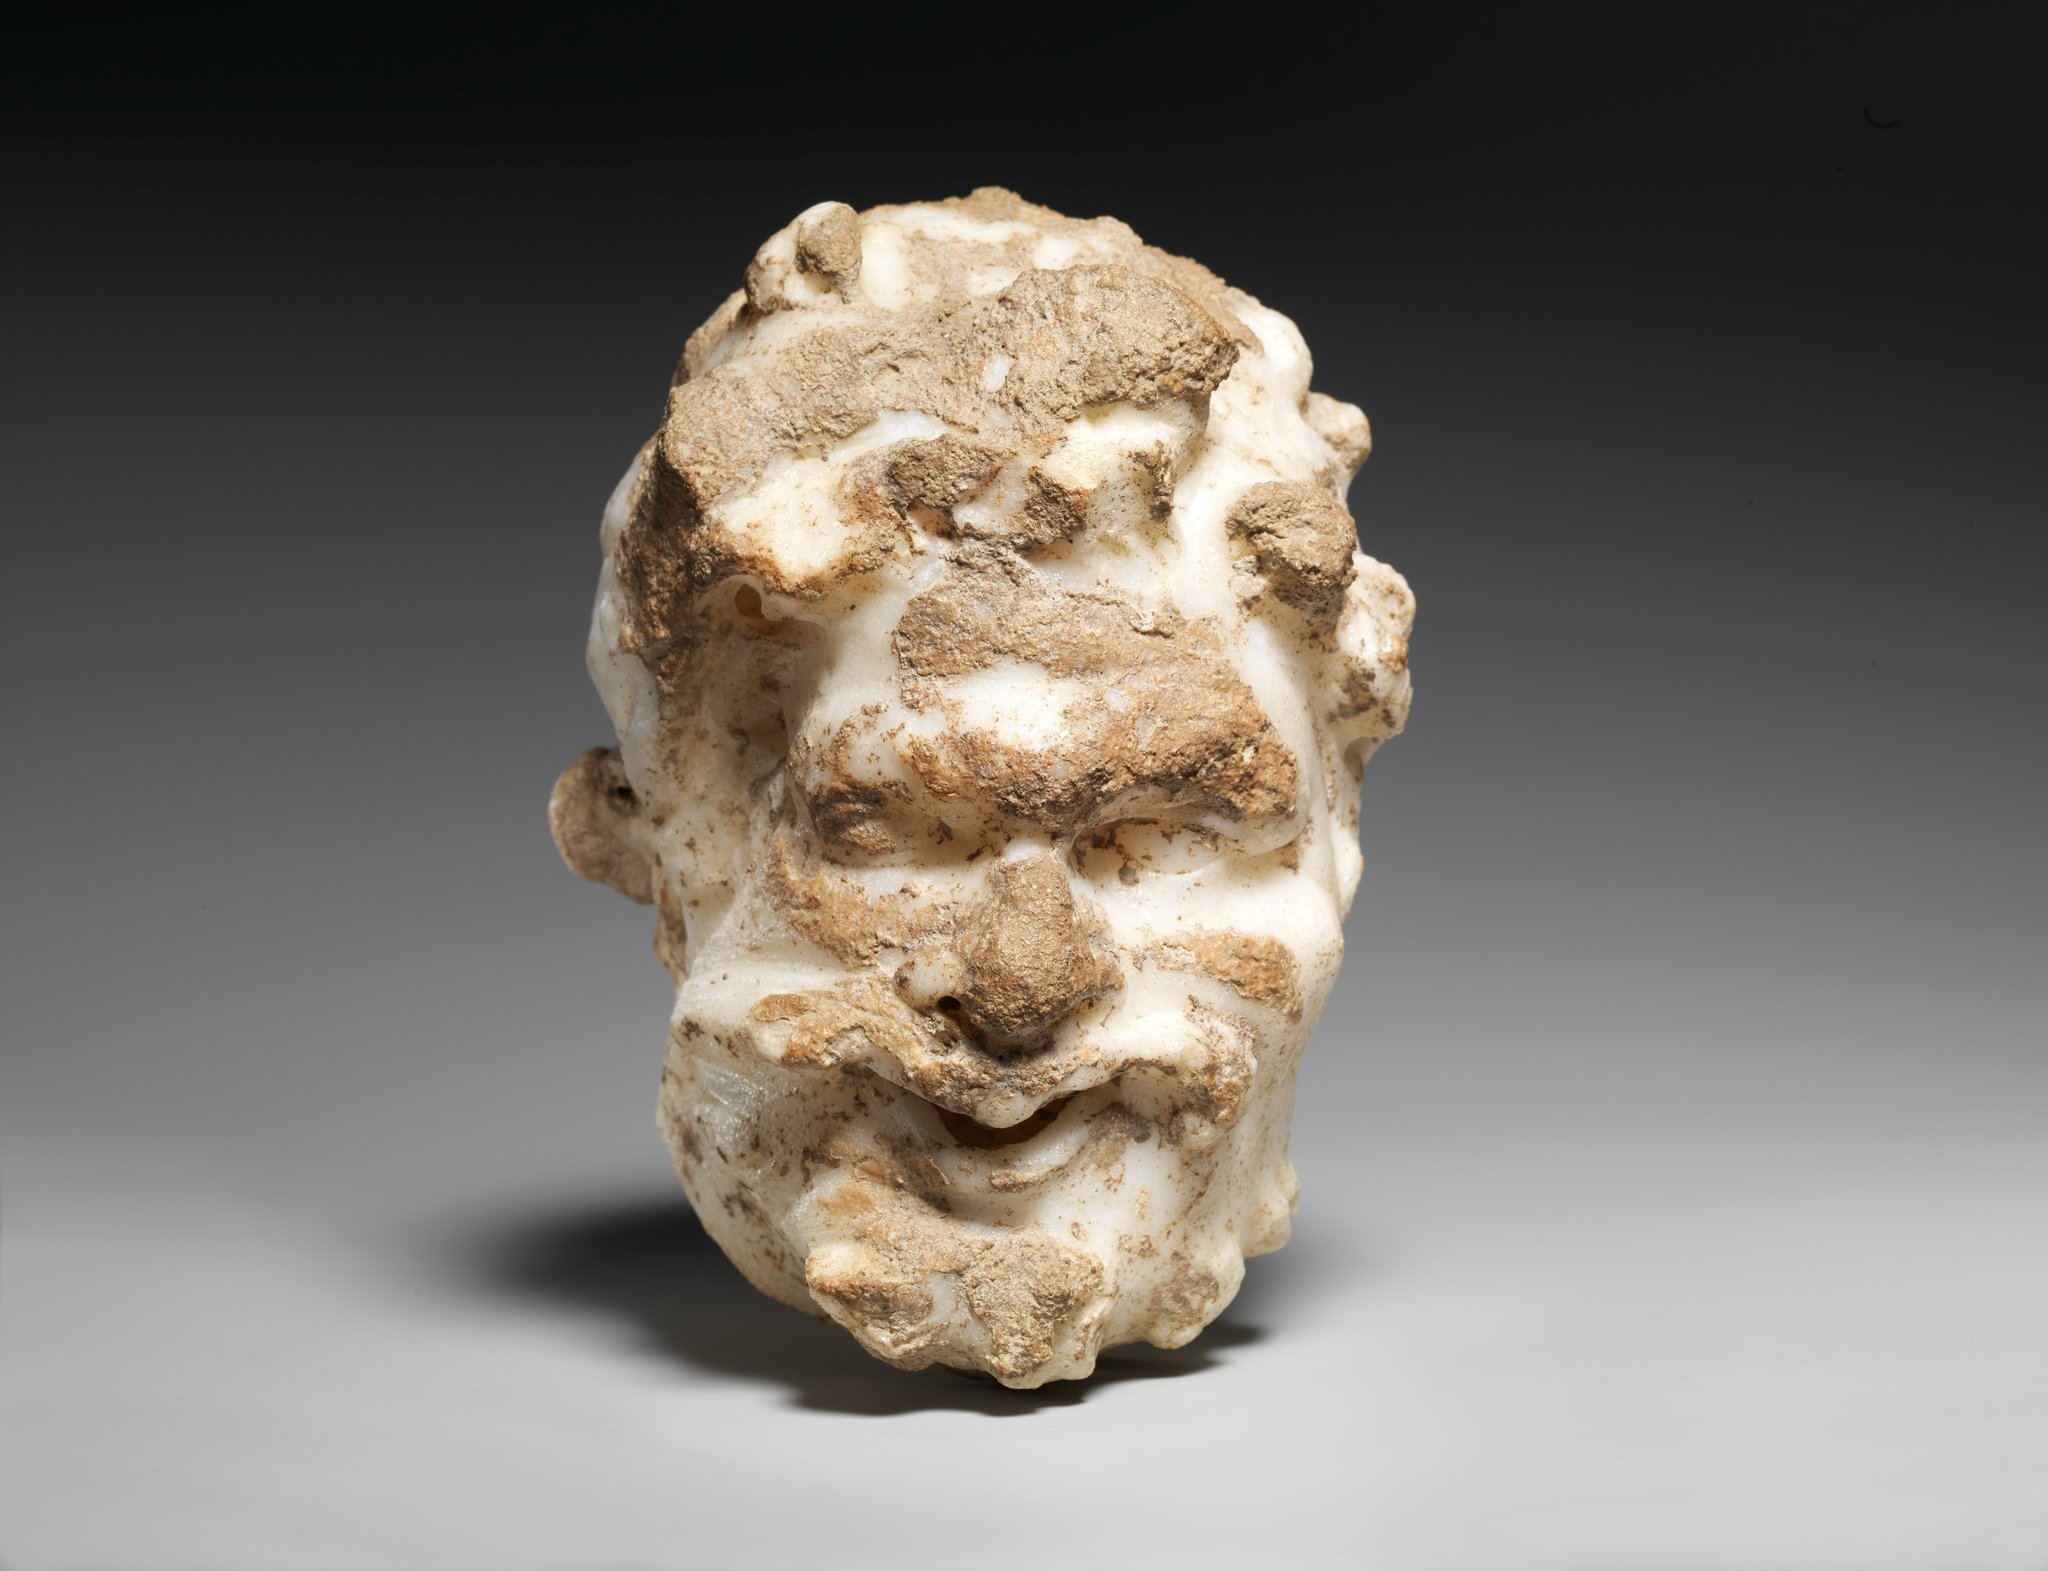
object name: head of a satyr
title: Marble head of a satyr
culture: greek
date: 300-1 BCE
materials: marble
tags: heads,satyrs